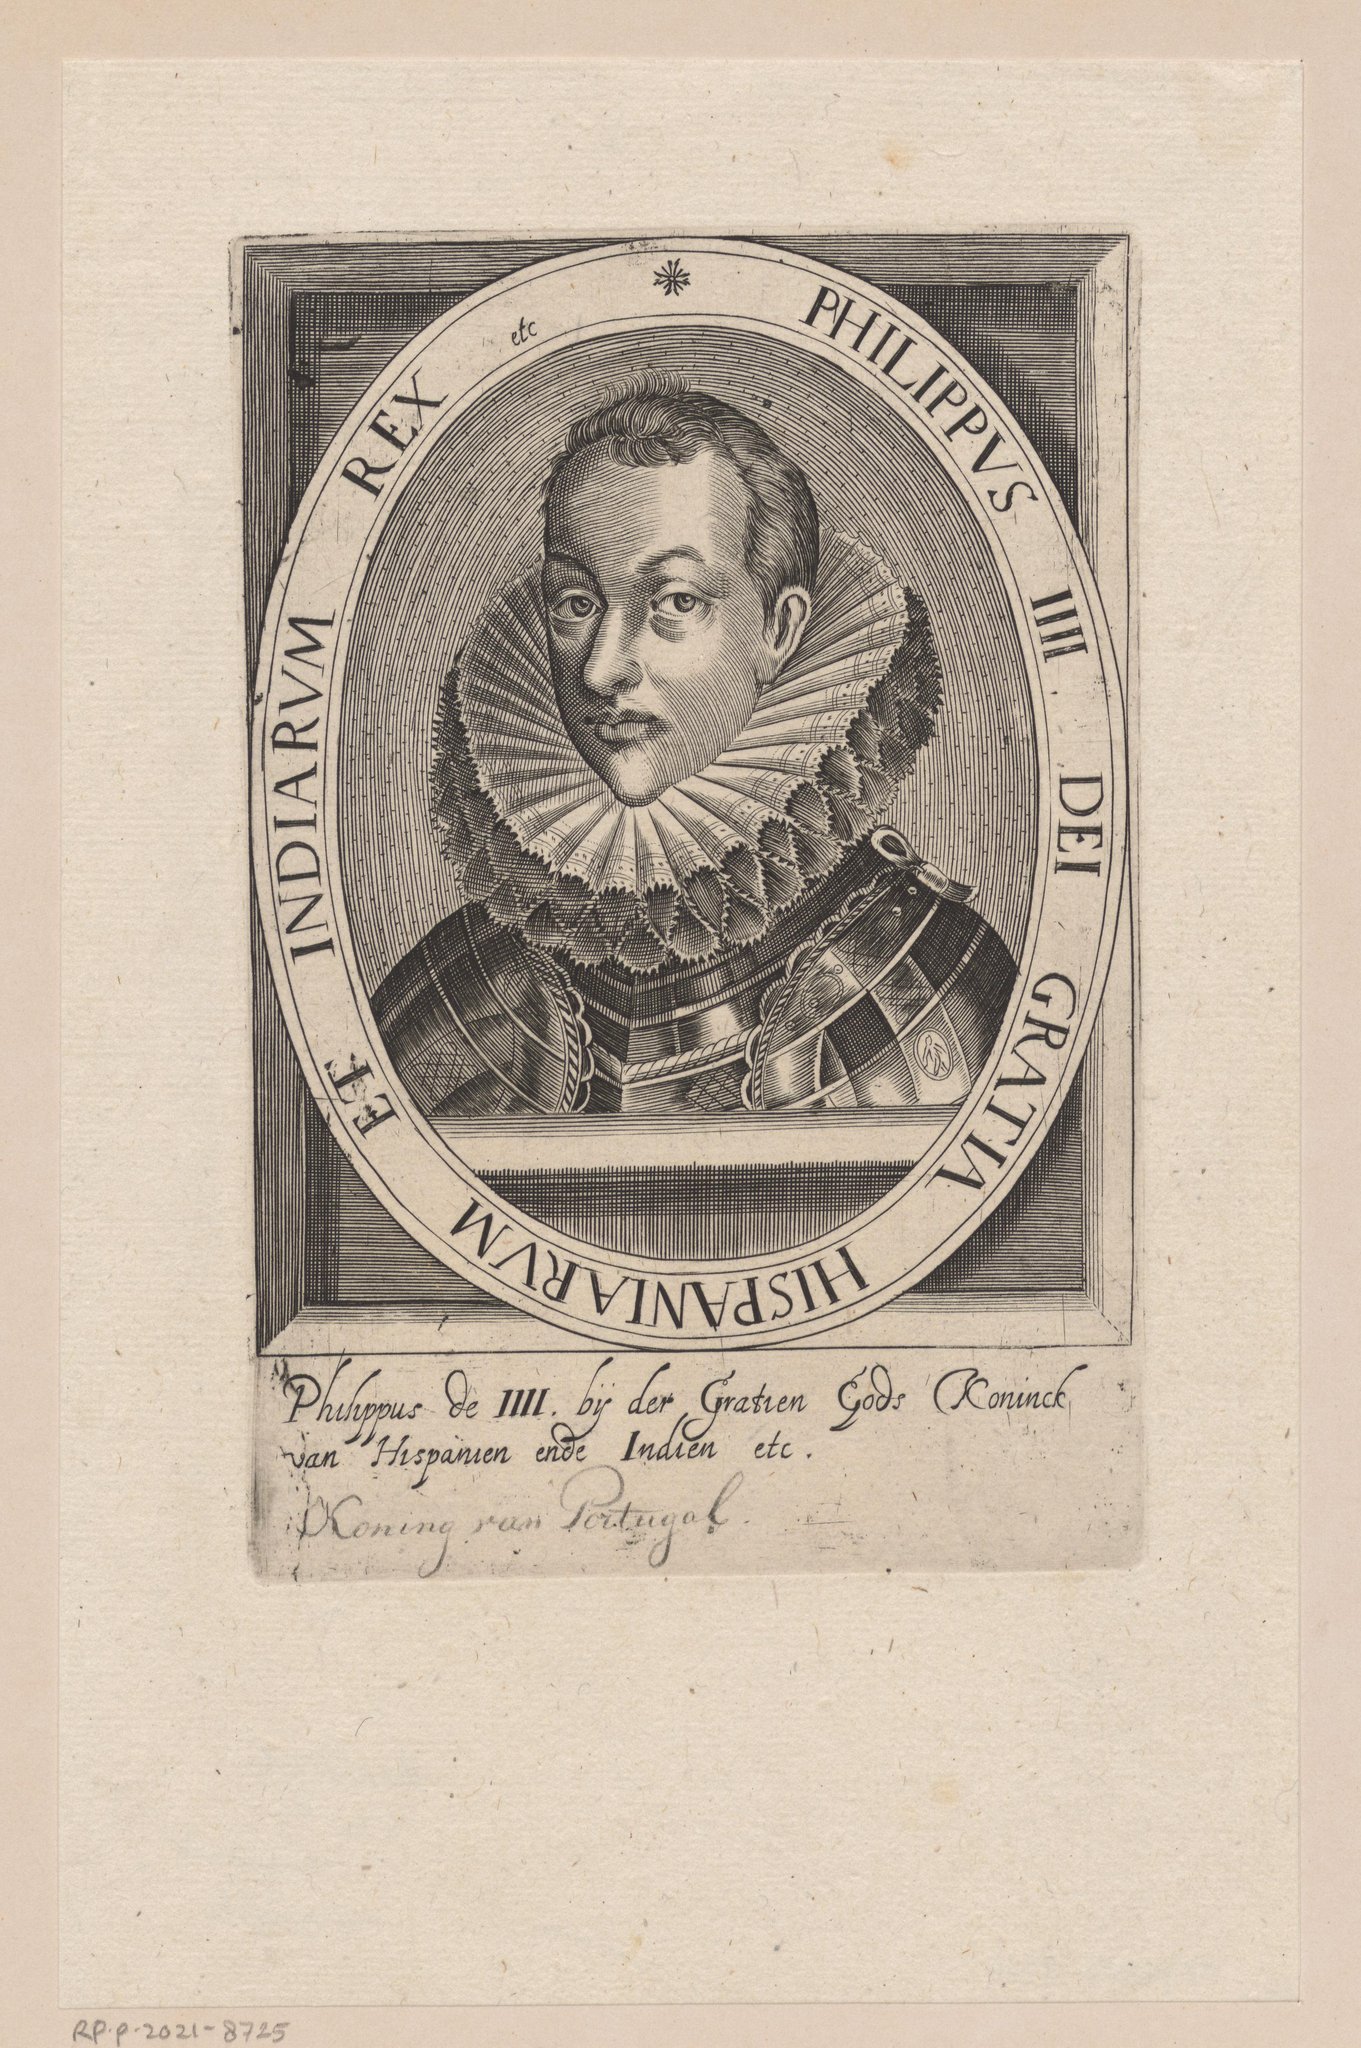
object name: print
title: Portret van Filips IV, koning van Spanje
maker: Anonymous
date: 1625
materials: paper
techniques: engraving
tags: filips iv (koning van spanje), historical persons, youth, adolescent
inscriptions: inscription: ‘Koning van Portugal’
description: Prent mogelijk uit: Baudartius, Willem. Het tweedde-deel der Memorien ofte cort verhael der gedenck-weerdichste so kercklicke als werltlicke gheschiedenissen van Nederland (...). Arnhem: Jan Janssen., 1625.